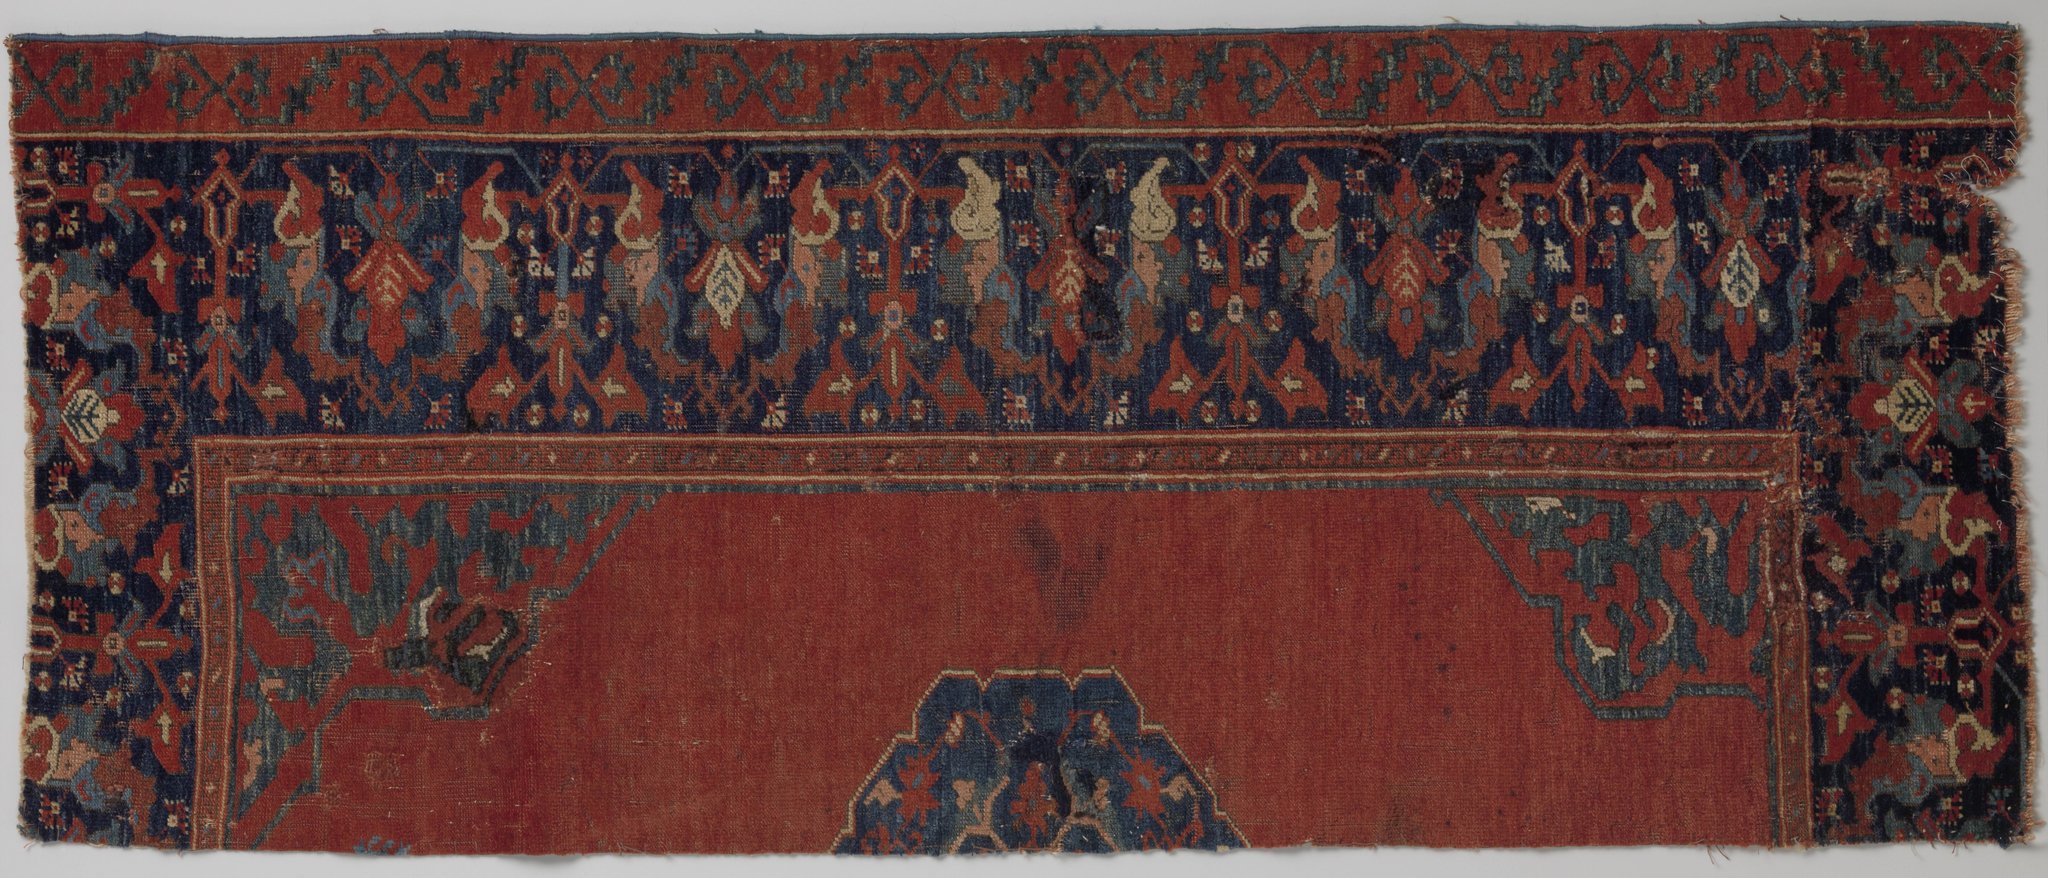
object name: fragment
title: Fragment van een Oosters tapijt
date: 1600-1699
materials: wool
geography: ushak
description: Fragment, rechter helft van een oosters tapijt, bidkleed, ushak-tapijt. Op het middenveld omega-vormige omlijsting van een dubbele mihrab. In het midden de helft van een rozet. De rand is versierd met hoekige bloemenranken.